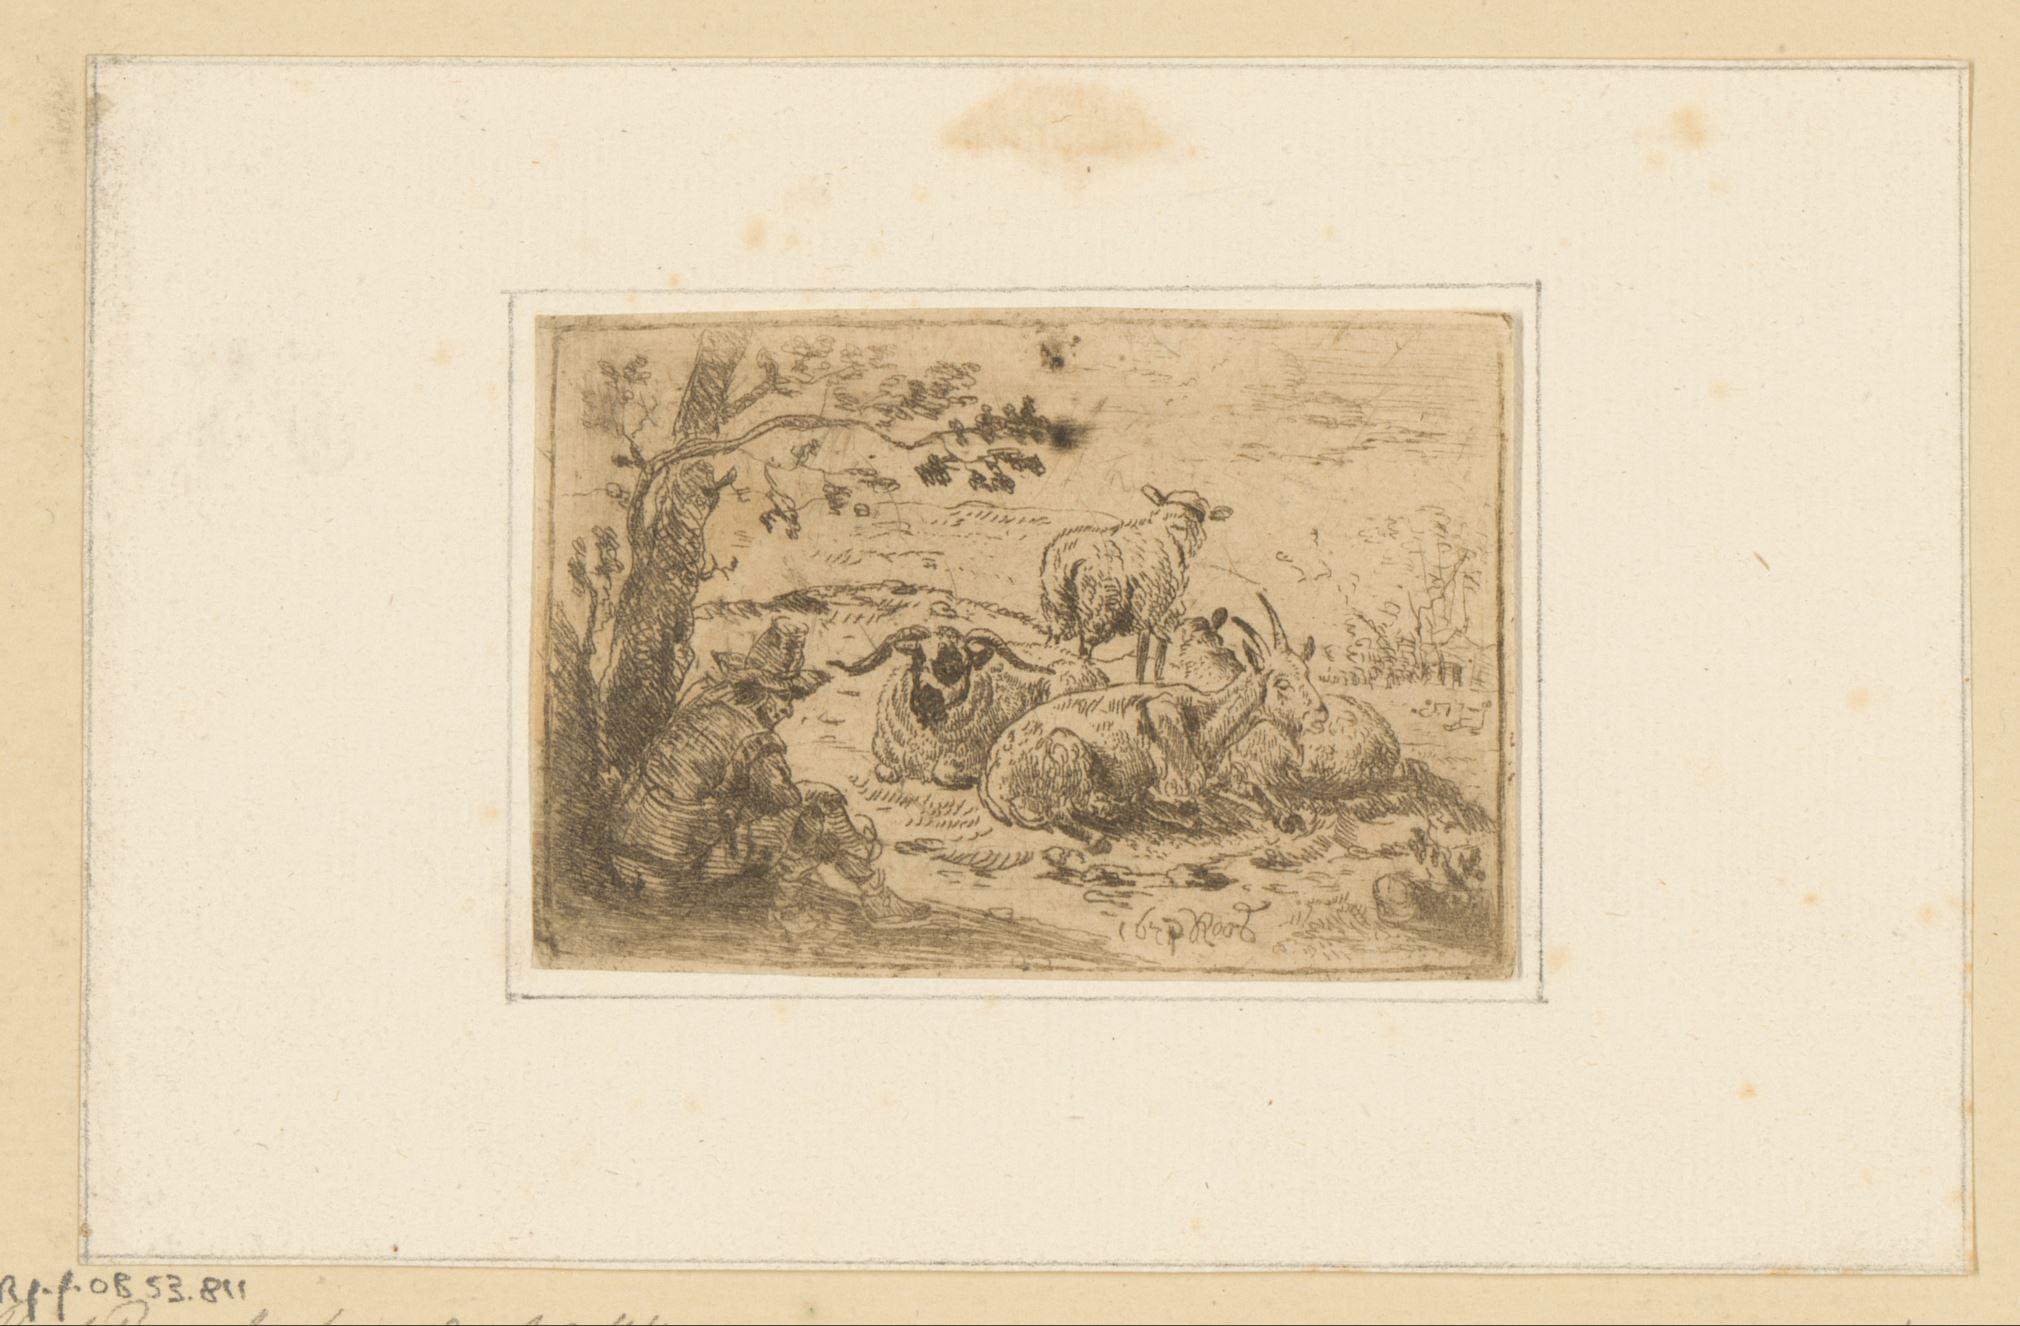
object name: print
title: Herder onder boom gezeten bij geit, ram en twee schapen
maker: Anonymous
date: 1650-1799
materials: paper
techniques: etching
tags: landscapes, herding, herdsman, herdswoman, shepherd, shepherdess, cowherd, etc., ram, sheep, goat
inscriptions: collector's mark: Lugt 240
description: Afgewezen als van Johann Heinrich Roos in Hollstein German.